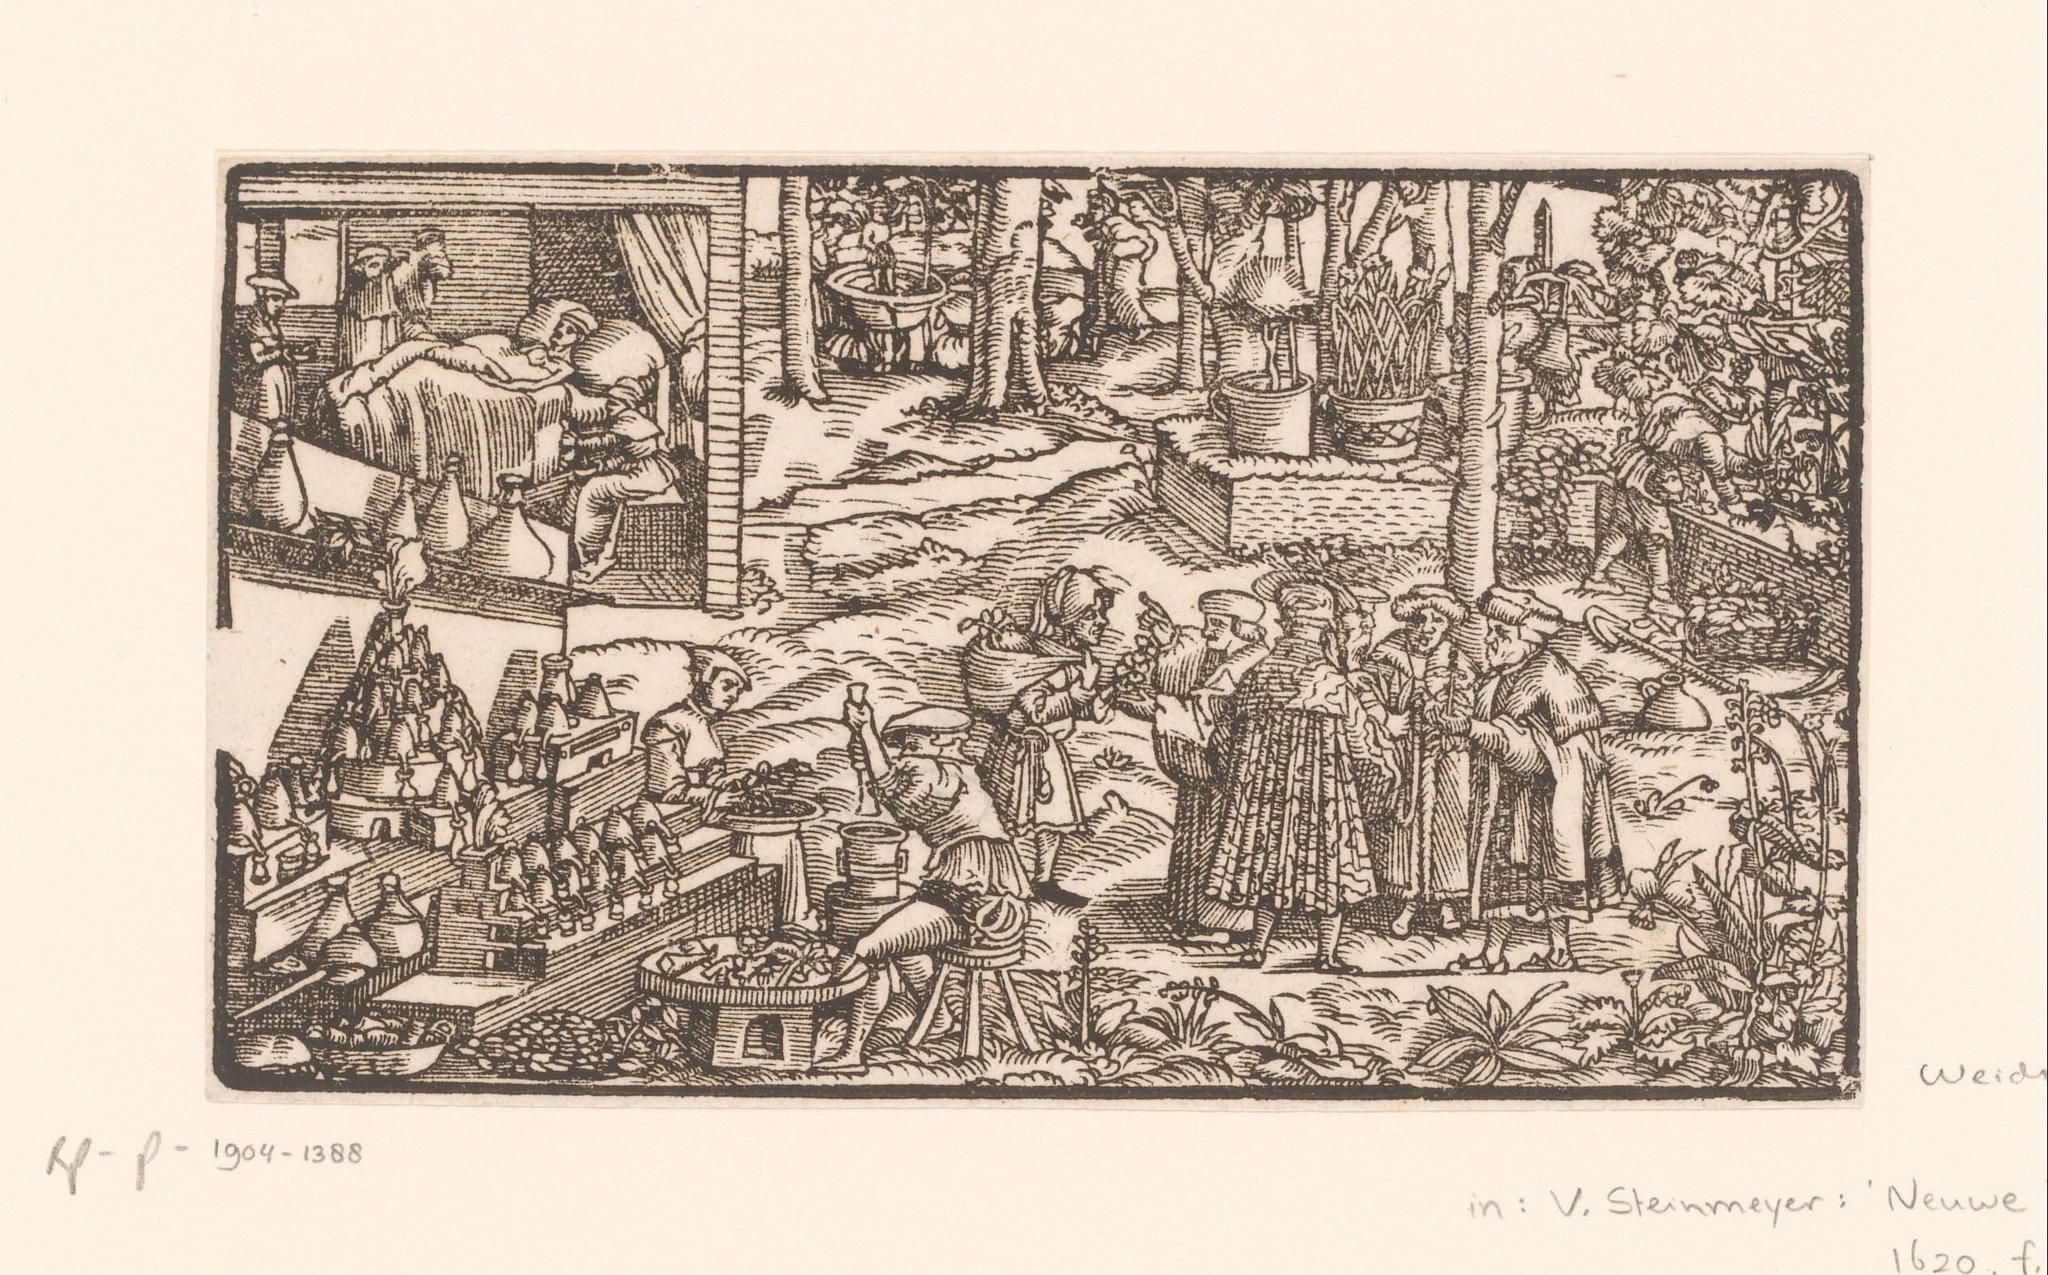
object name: book illustration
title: Illustraties uit "Newe Künstliche Wohlgerissene unnd in Holtz geschnittene Figuren (...)", uitgave V. Steinmeyer,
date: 1500-1550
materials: paper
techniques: woodcut